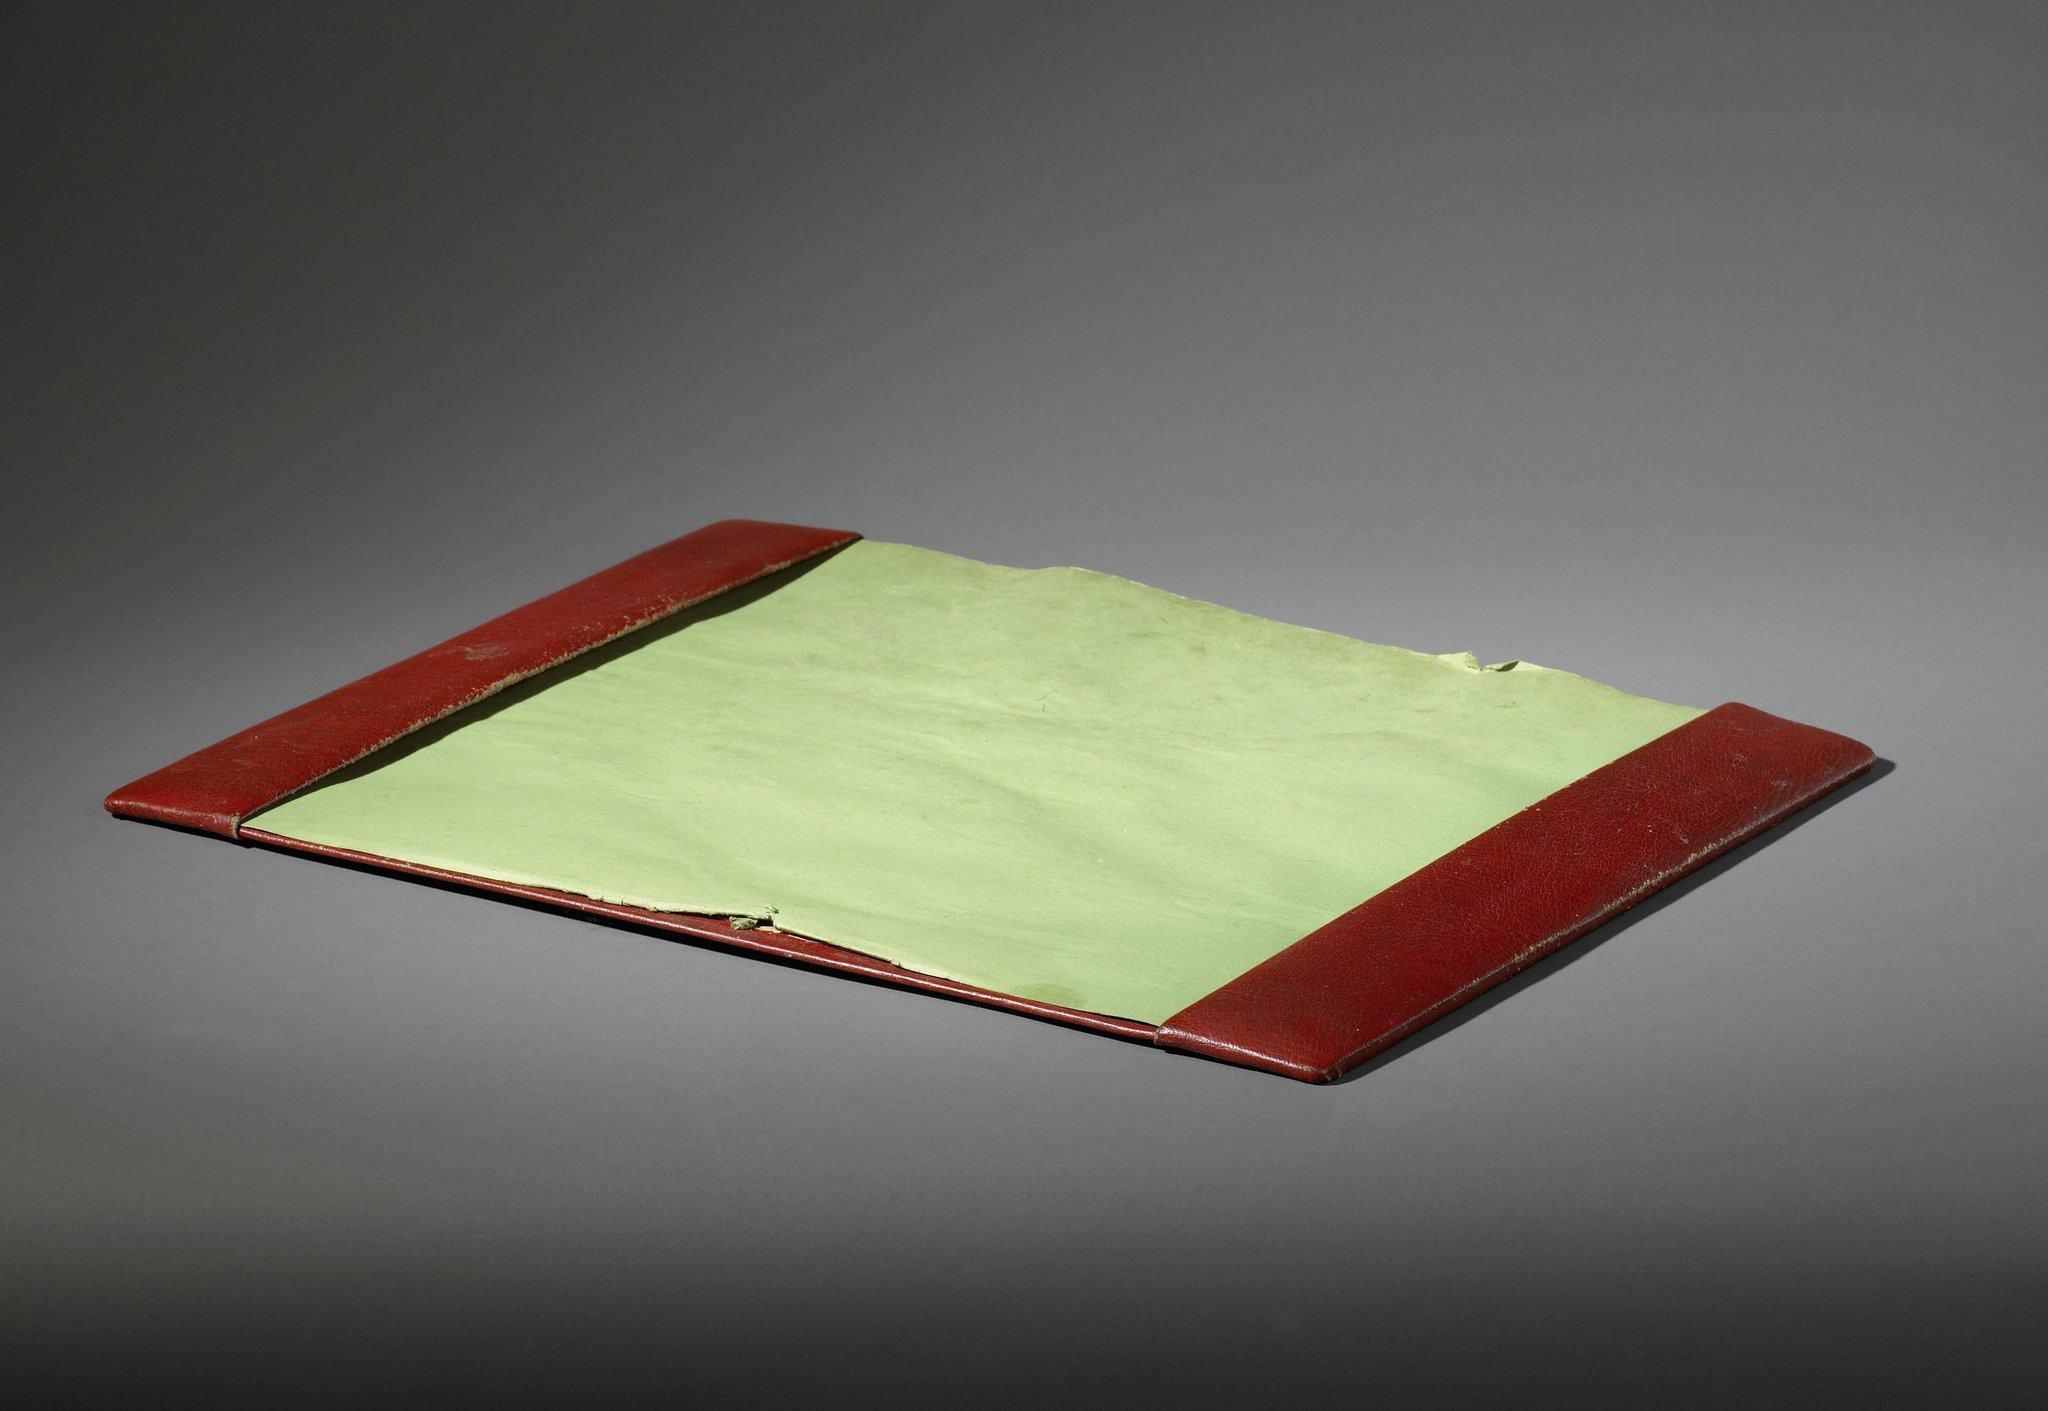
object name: vloeiblad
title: Vloeiblad van het bureau van Willem Drees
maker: Anonymous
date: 1910-1980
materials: cardboard, felt, leather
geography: netherlands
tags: amsterdam, the hague, willem drees, netherlands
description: Rood leren vloeiblad waarin een groen inlegvel. Onderzijde voorzien van bruin vilt.